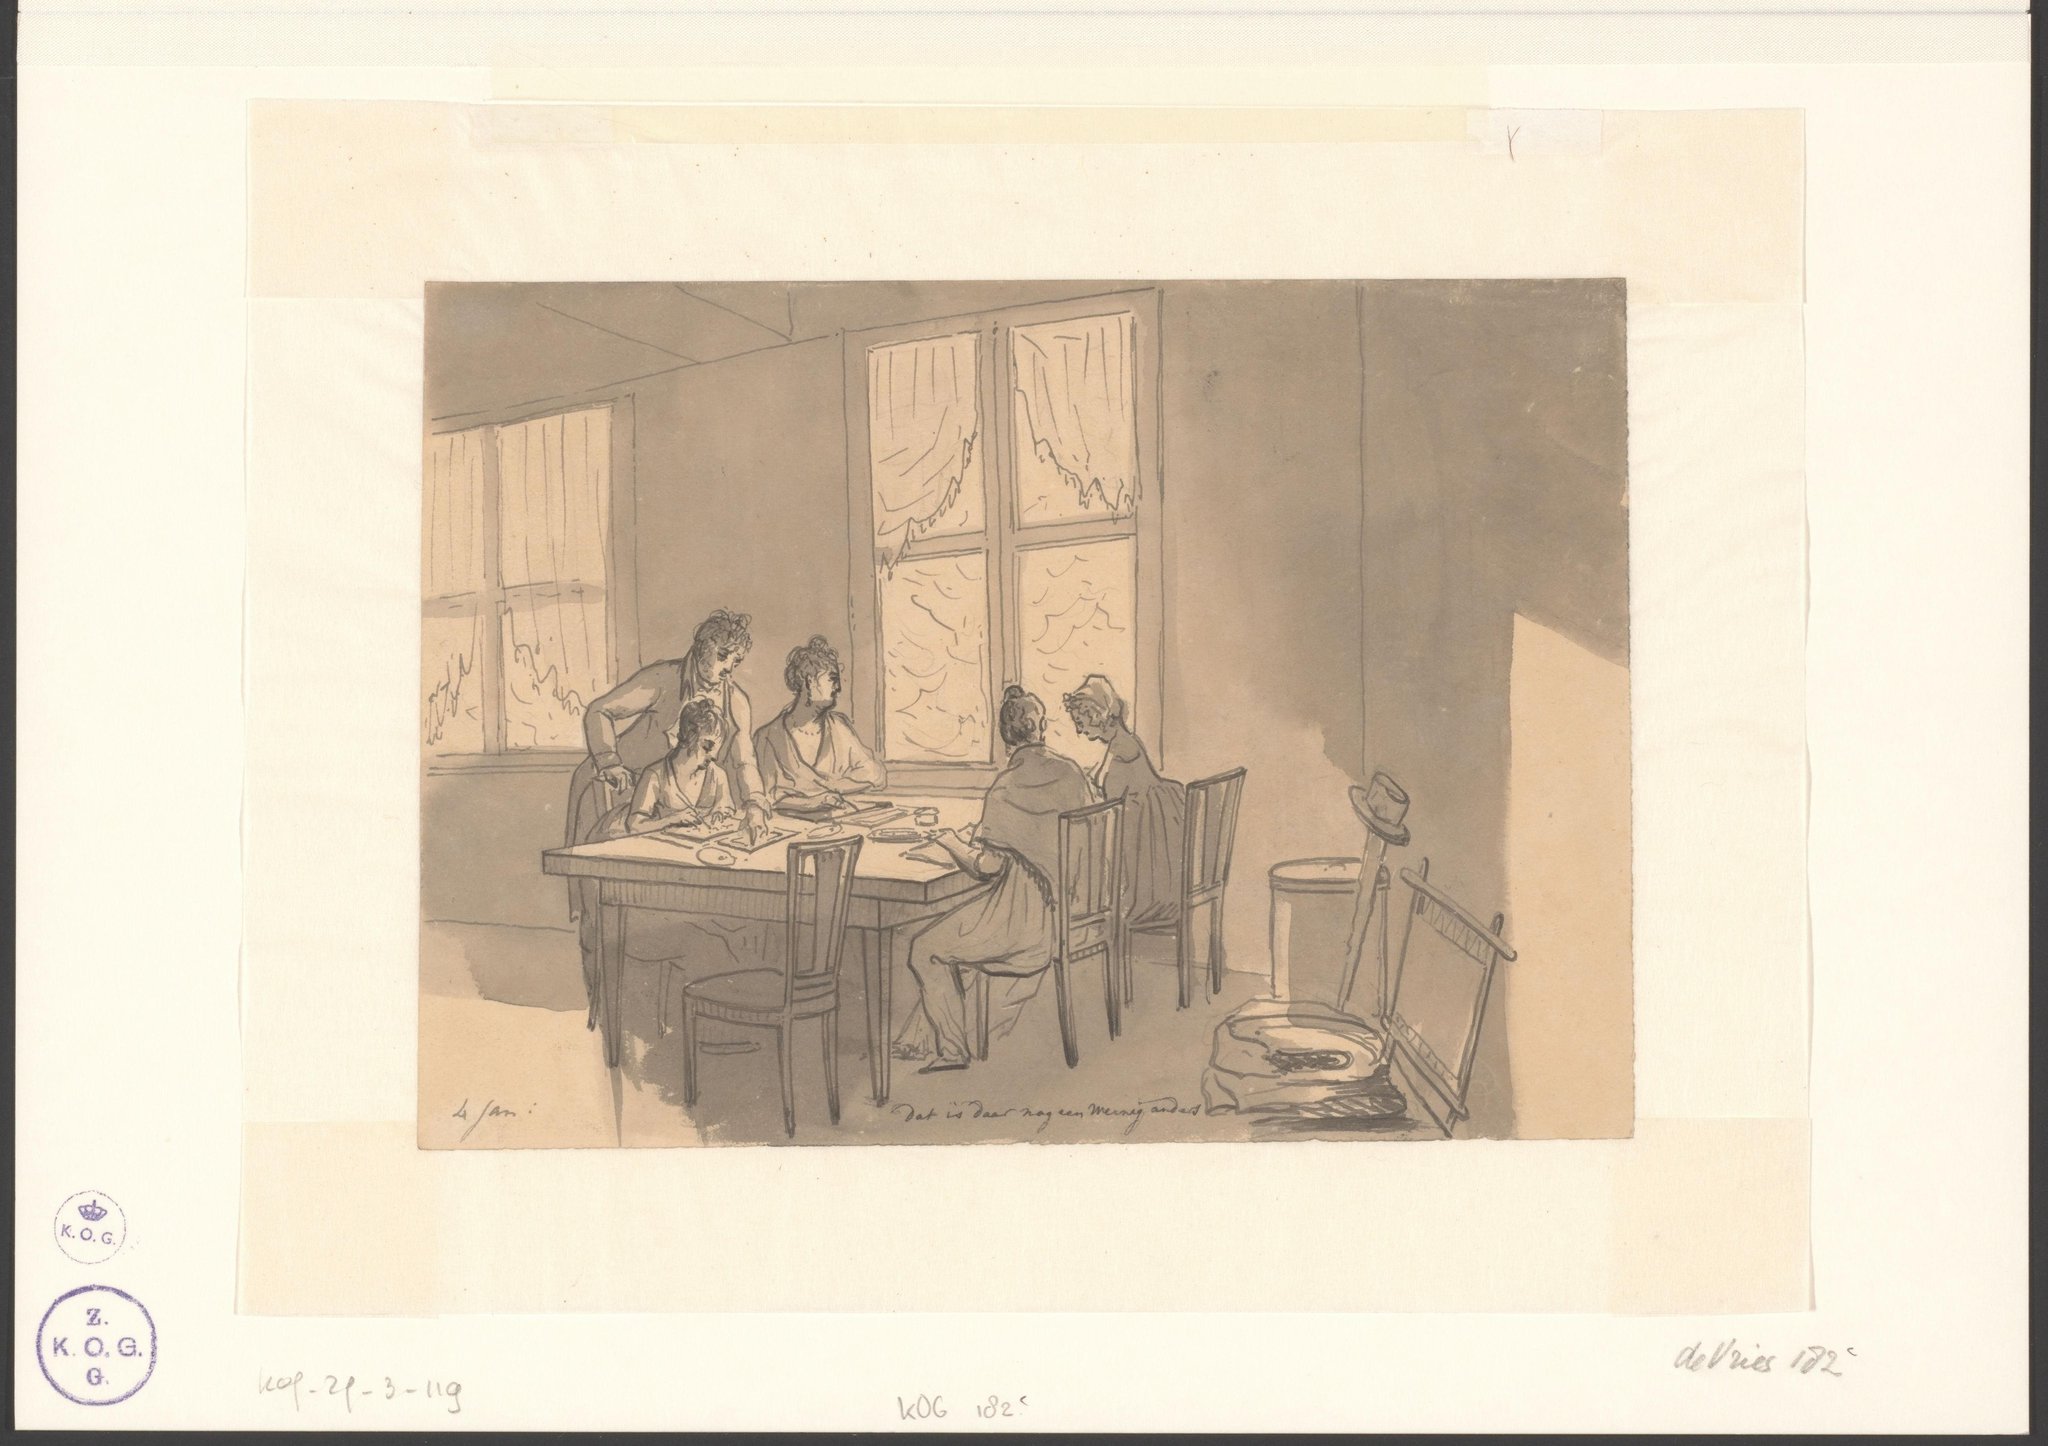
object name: print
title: Vier vrouwen krijgen tekenles van Christiaan Andriessen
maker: christiaan andriessen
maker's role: draughtsman, print maker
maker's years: 1775-1846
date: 1805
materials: ink, paper, pencil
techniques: brush, pen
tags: amsterdam, print maker, draughtsman, christiaan andriessen, sitting figure - aa - female human figure, drawing-lesson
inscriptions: collector's mark: Lugt 1641a, inscription: ‘4 jan: dat is daar nog een weinig anders’, collector's mark: Lugt 1641, signature:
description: Christiaan Andriessen geeft aanwijzingen aan één van de vier vrouwen aan wie hij hier les geeft. Vrijwel zeker zijn dit mevrouw Umbgrove en haar drie dochters, op Herengracht 548.